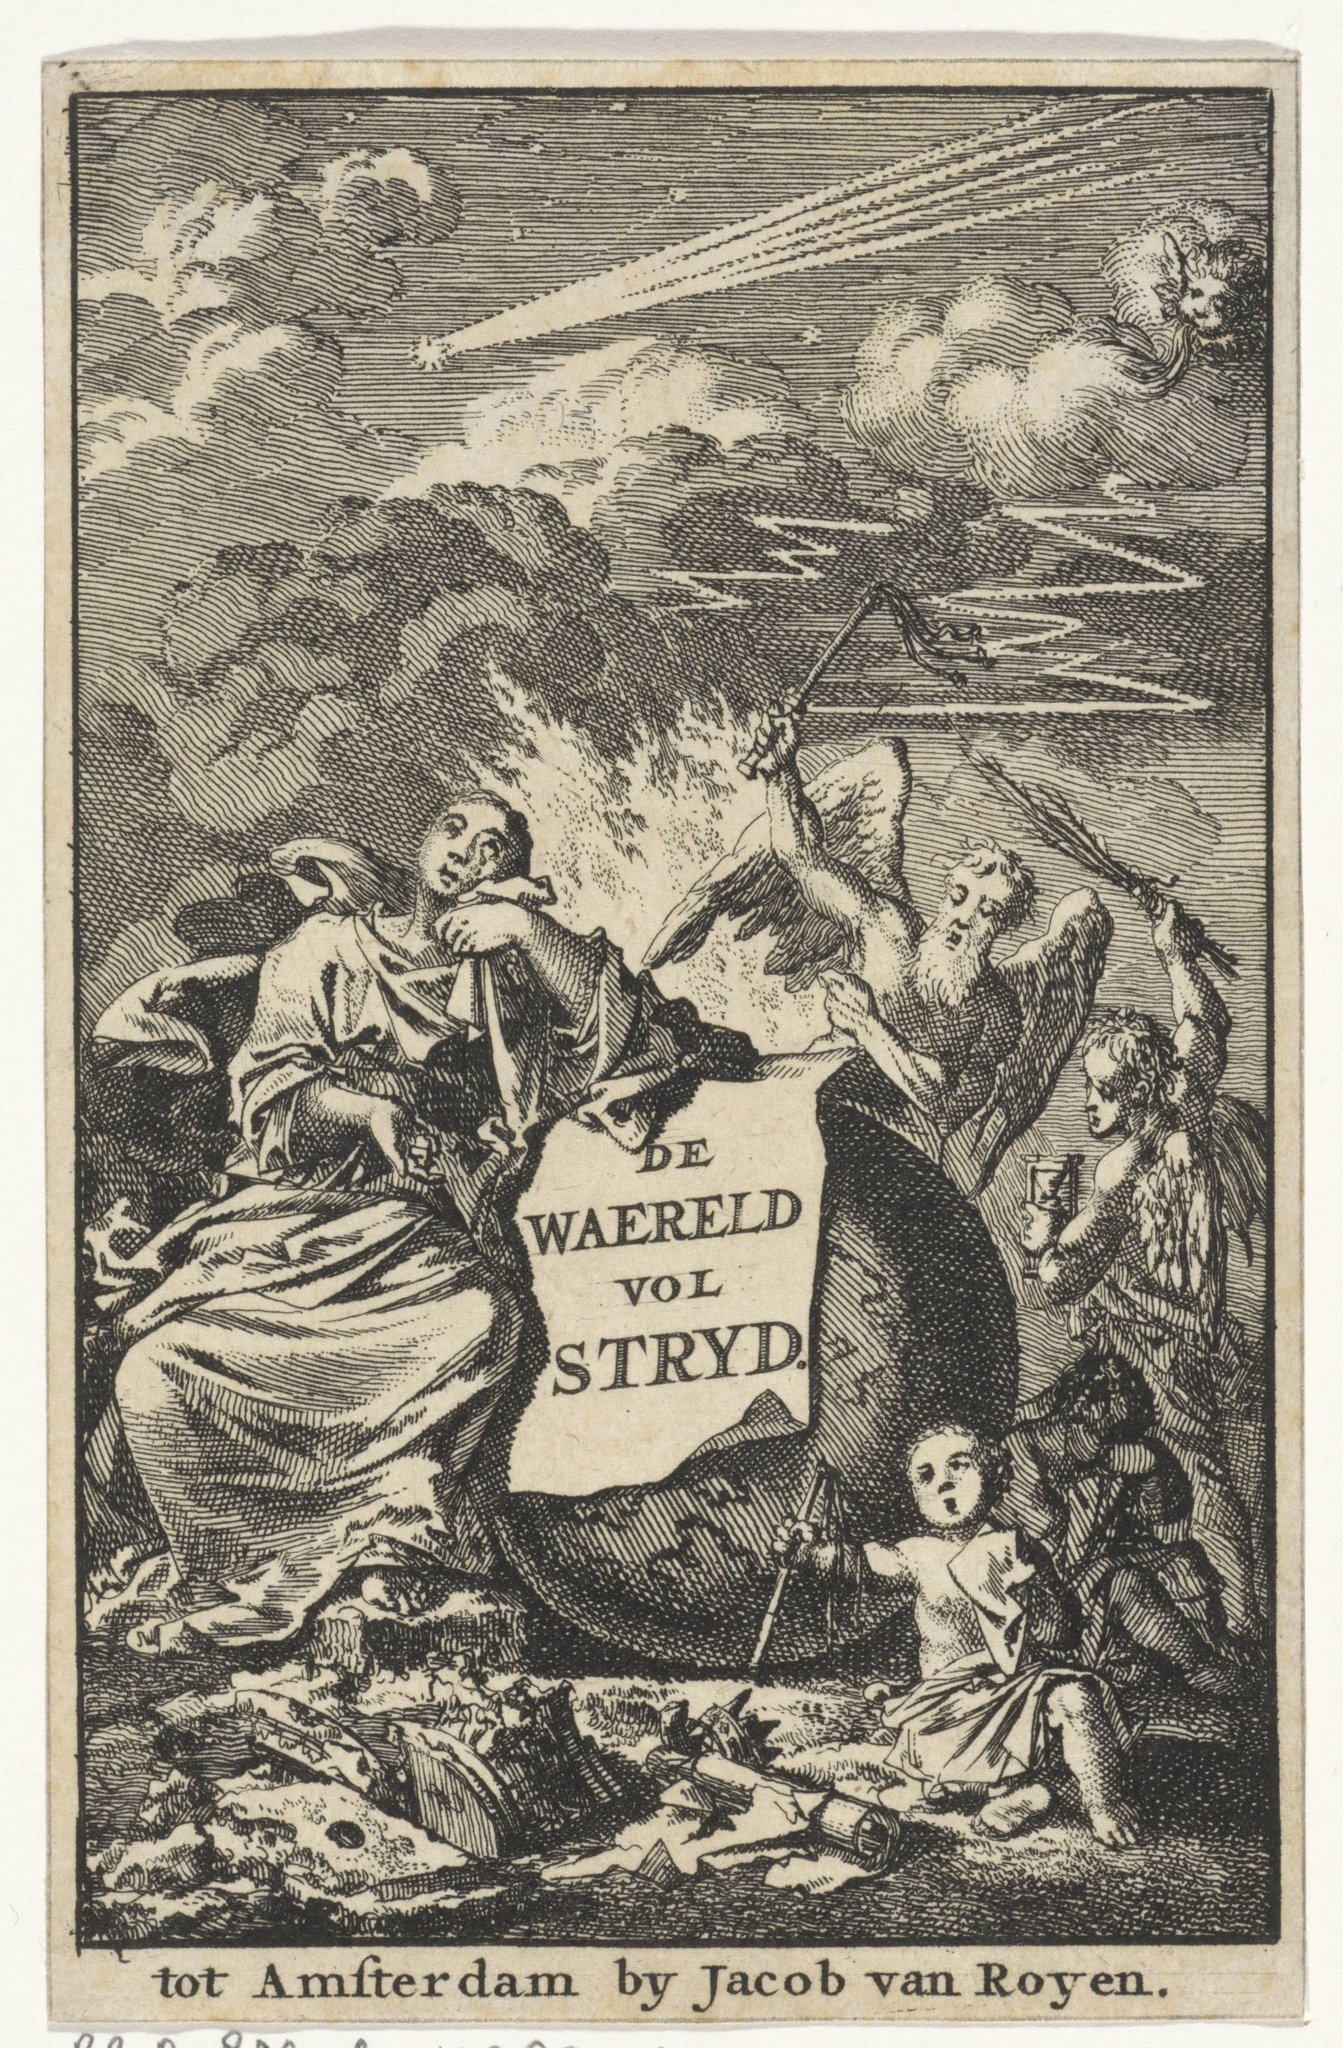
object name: titelblad, titelpagina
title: Titelpagina voor: 'Waereld vol Stryd', 1706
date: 1706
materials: paper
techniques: etching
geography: amsterdam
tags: earth, world as celestial body, crying, shouting, father time, man with wings and scythe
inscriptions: collector's mark: Lugt 2228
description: De wereldbol wordt geflankeerd door twee huilende kinderen en een wenende vrouw. Op de achtergrond de oude en de nieuwe tijd.